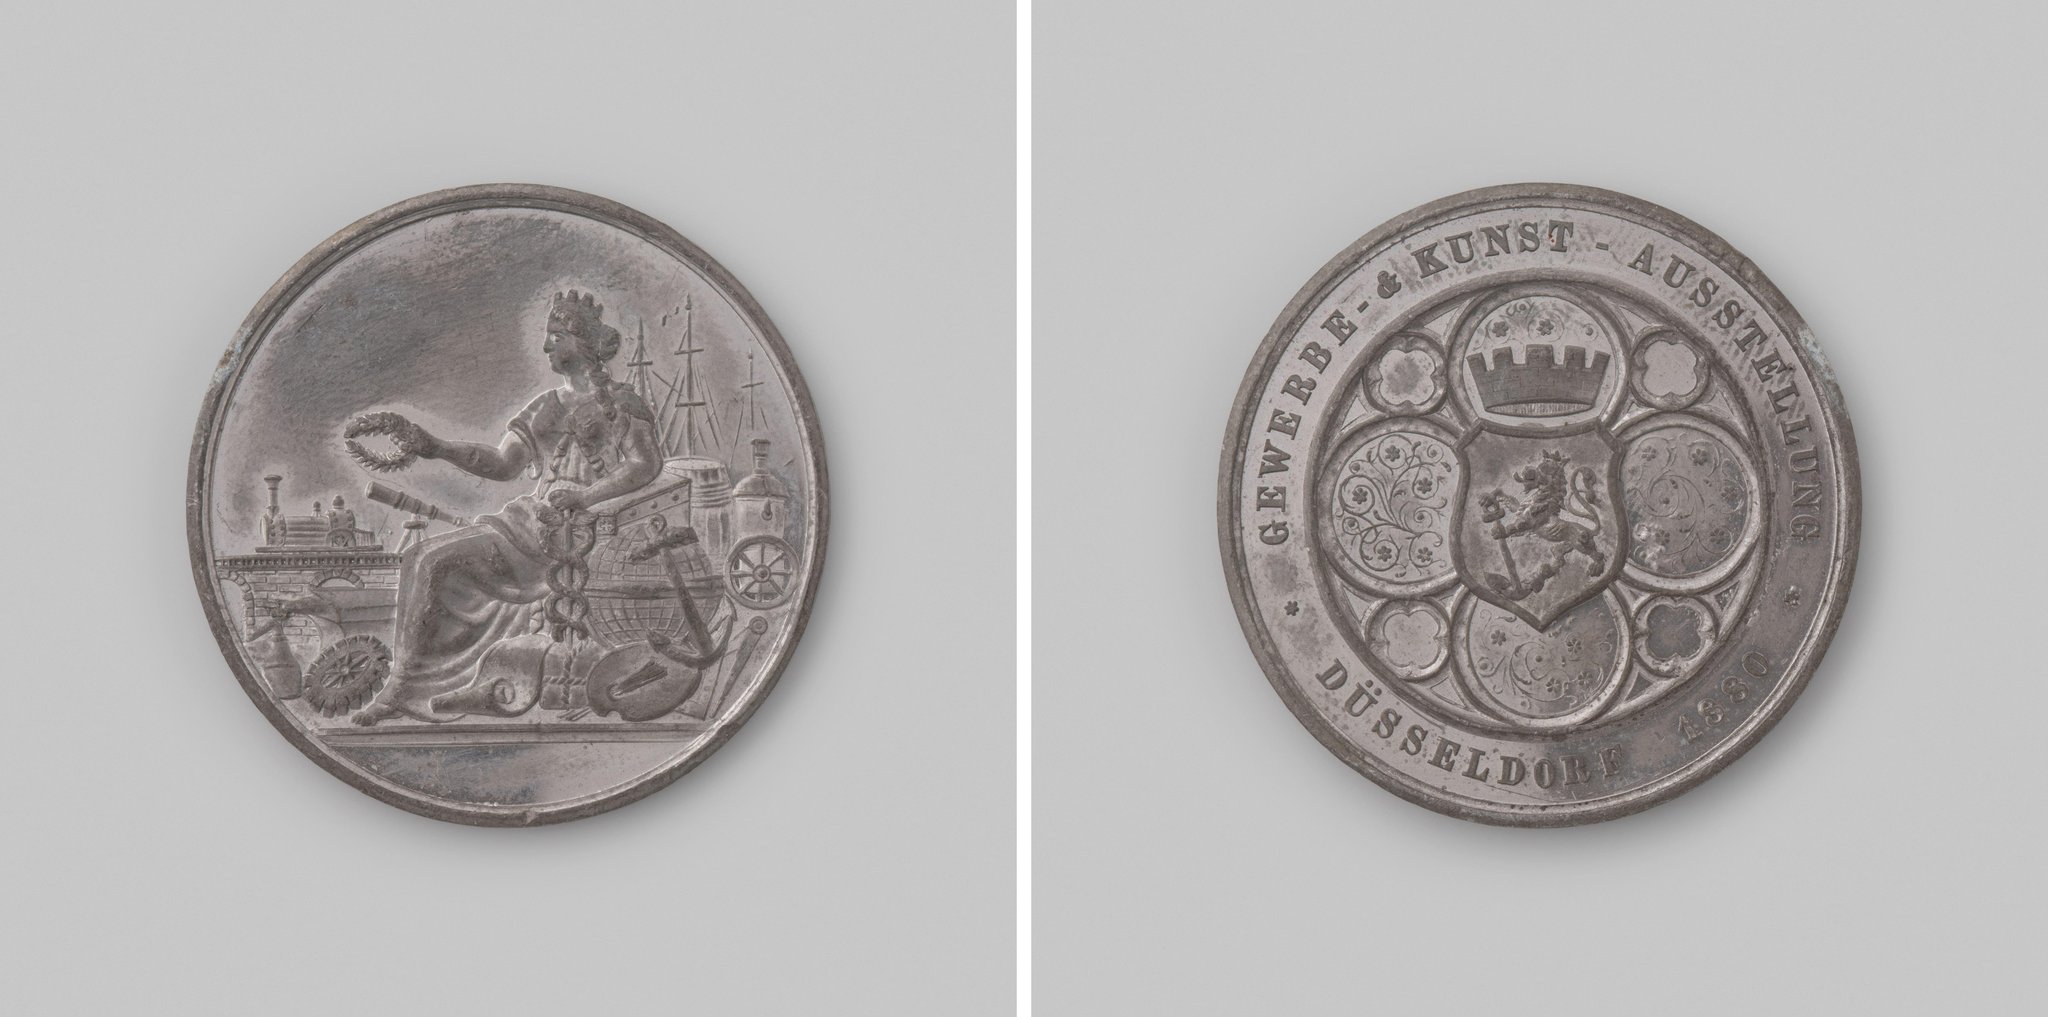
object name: history medal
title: Kunstnijverheidstentoonstelling Gewerbe & Kunst in Düsseldorf 1880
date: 1880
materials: tin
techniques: striking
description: Tinnen penning, op de voorzijde een tronende vrouw te midden van handels- en nijverheidssymblen, op de keerzijde het gekroonde wapenschild van Düsseldorf tussen versierde cirkels en vierpassen, met omschrift.